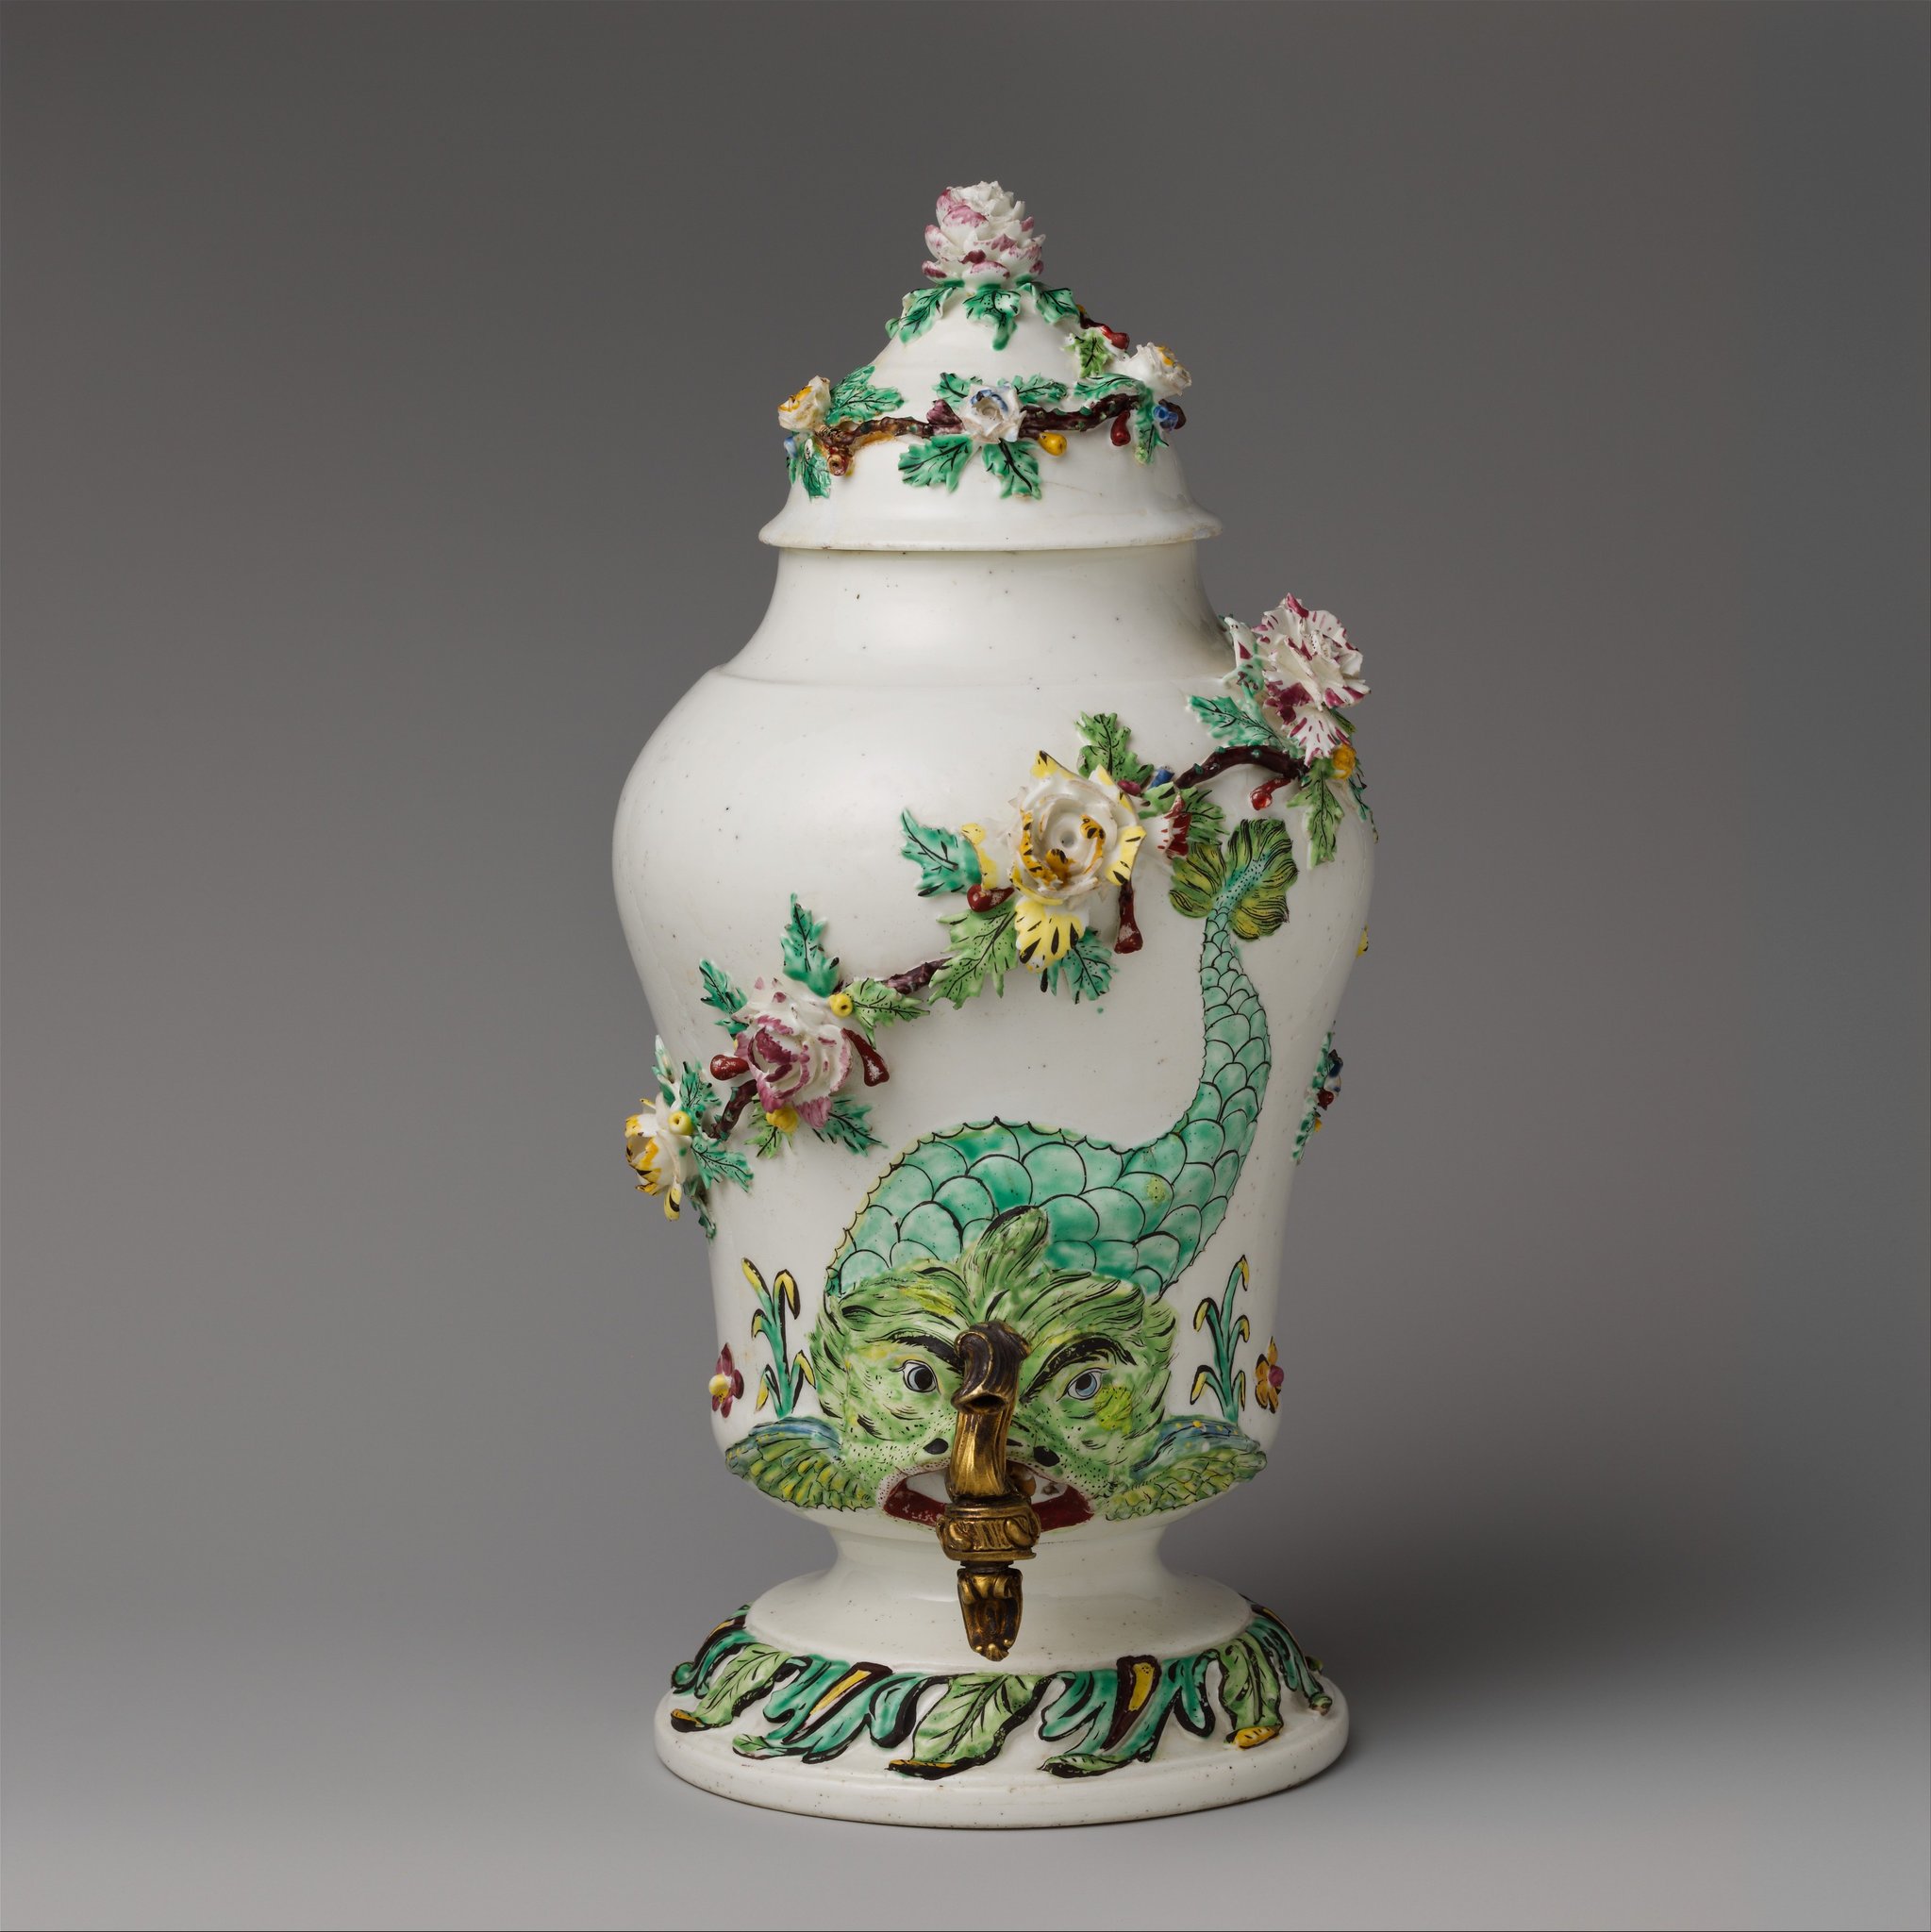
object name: fountain with cover and spigot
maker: mennecy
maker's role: factory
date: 1745-1750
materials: gilt bronze, soft paste porcelain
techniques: glazing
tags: dolphins,flowers